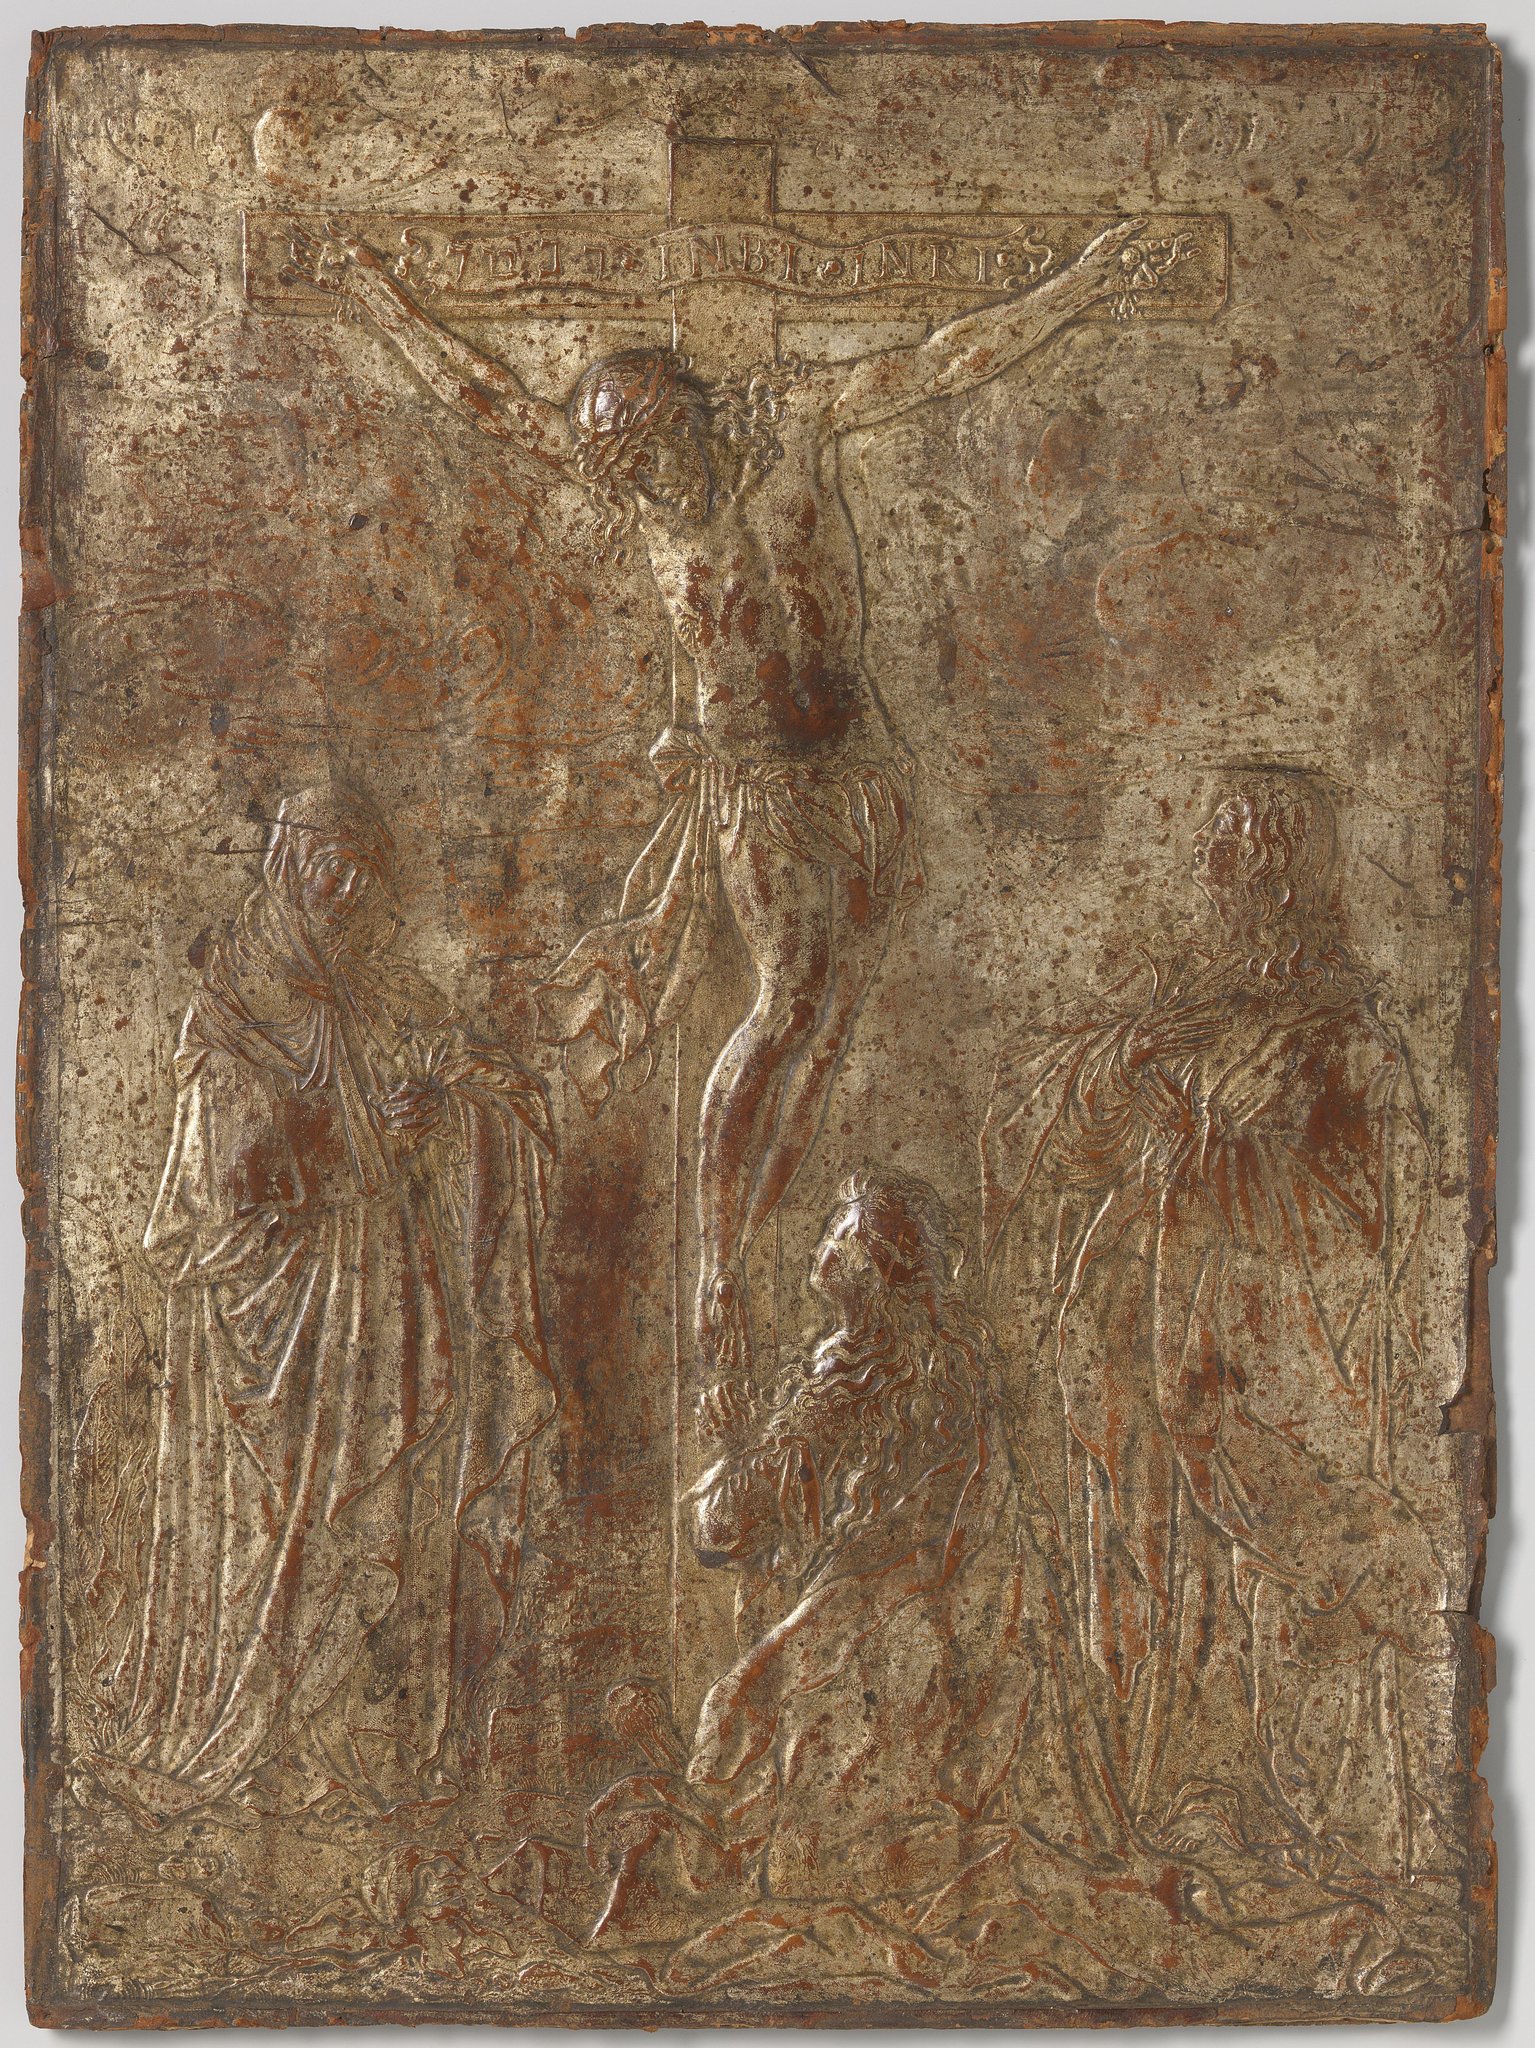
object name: panel surface component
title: Paneel van goudleer met Kruisiging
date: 1655-1660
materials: leather, wood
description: Paneel van goudleer, zilverkleurig, op eikenhouten drager, met de gekruisigde Christus met Maria, Johannes en Maria Magdalena. Op een banderol op het kruis de letters 'INRI' in het Hebreeuws, het Grieks en het Latijn, links van de onderzijde van het kruis het opschrift MORS REDEVIVA PIIS. Amsterdam, ca. 1658, door Willem van den Heuvel of Jacob Hamer. Op de achterzijde: in zwart: L 250 (vermoedelijk 18de-eeuwse hand) en in rood: CAT No 28.